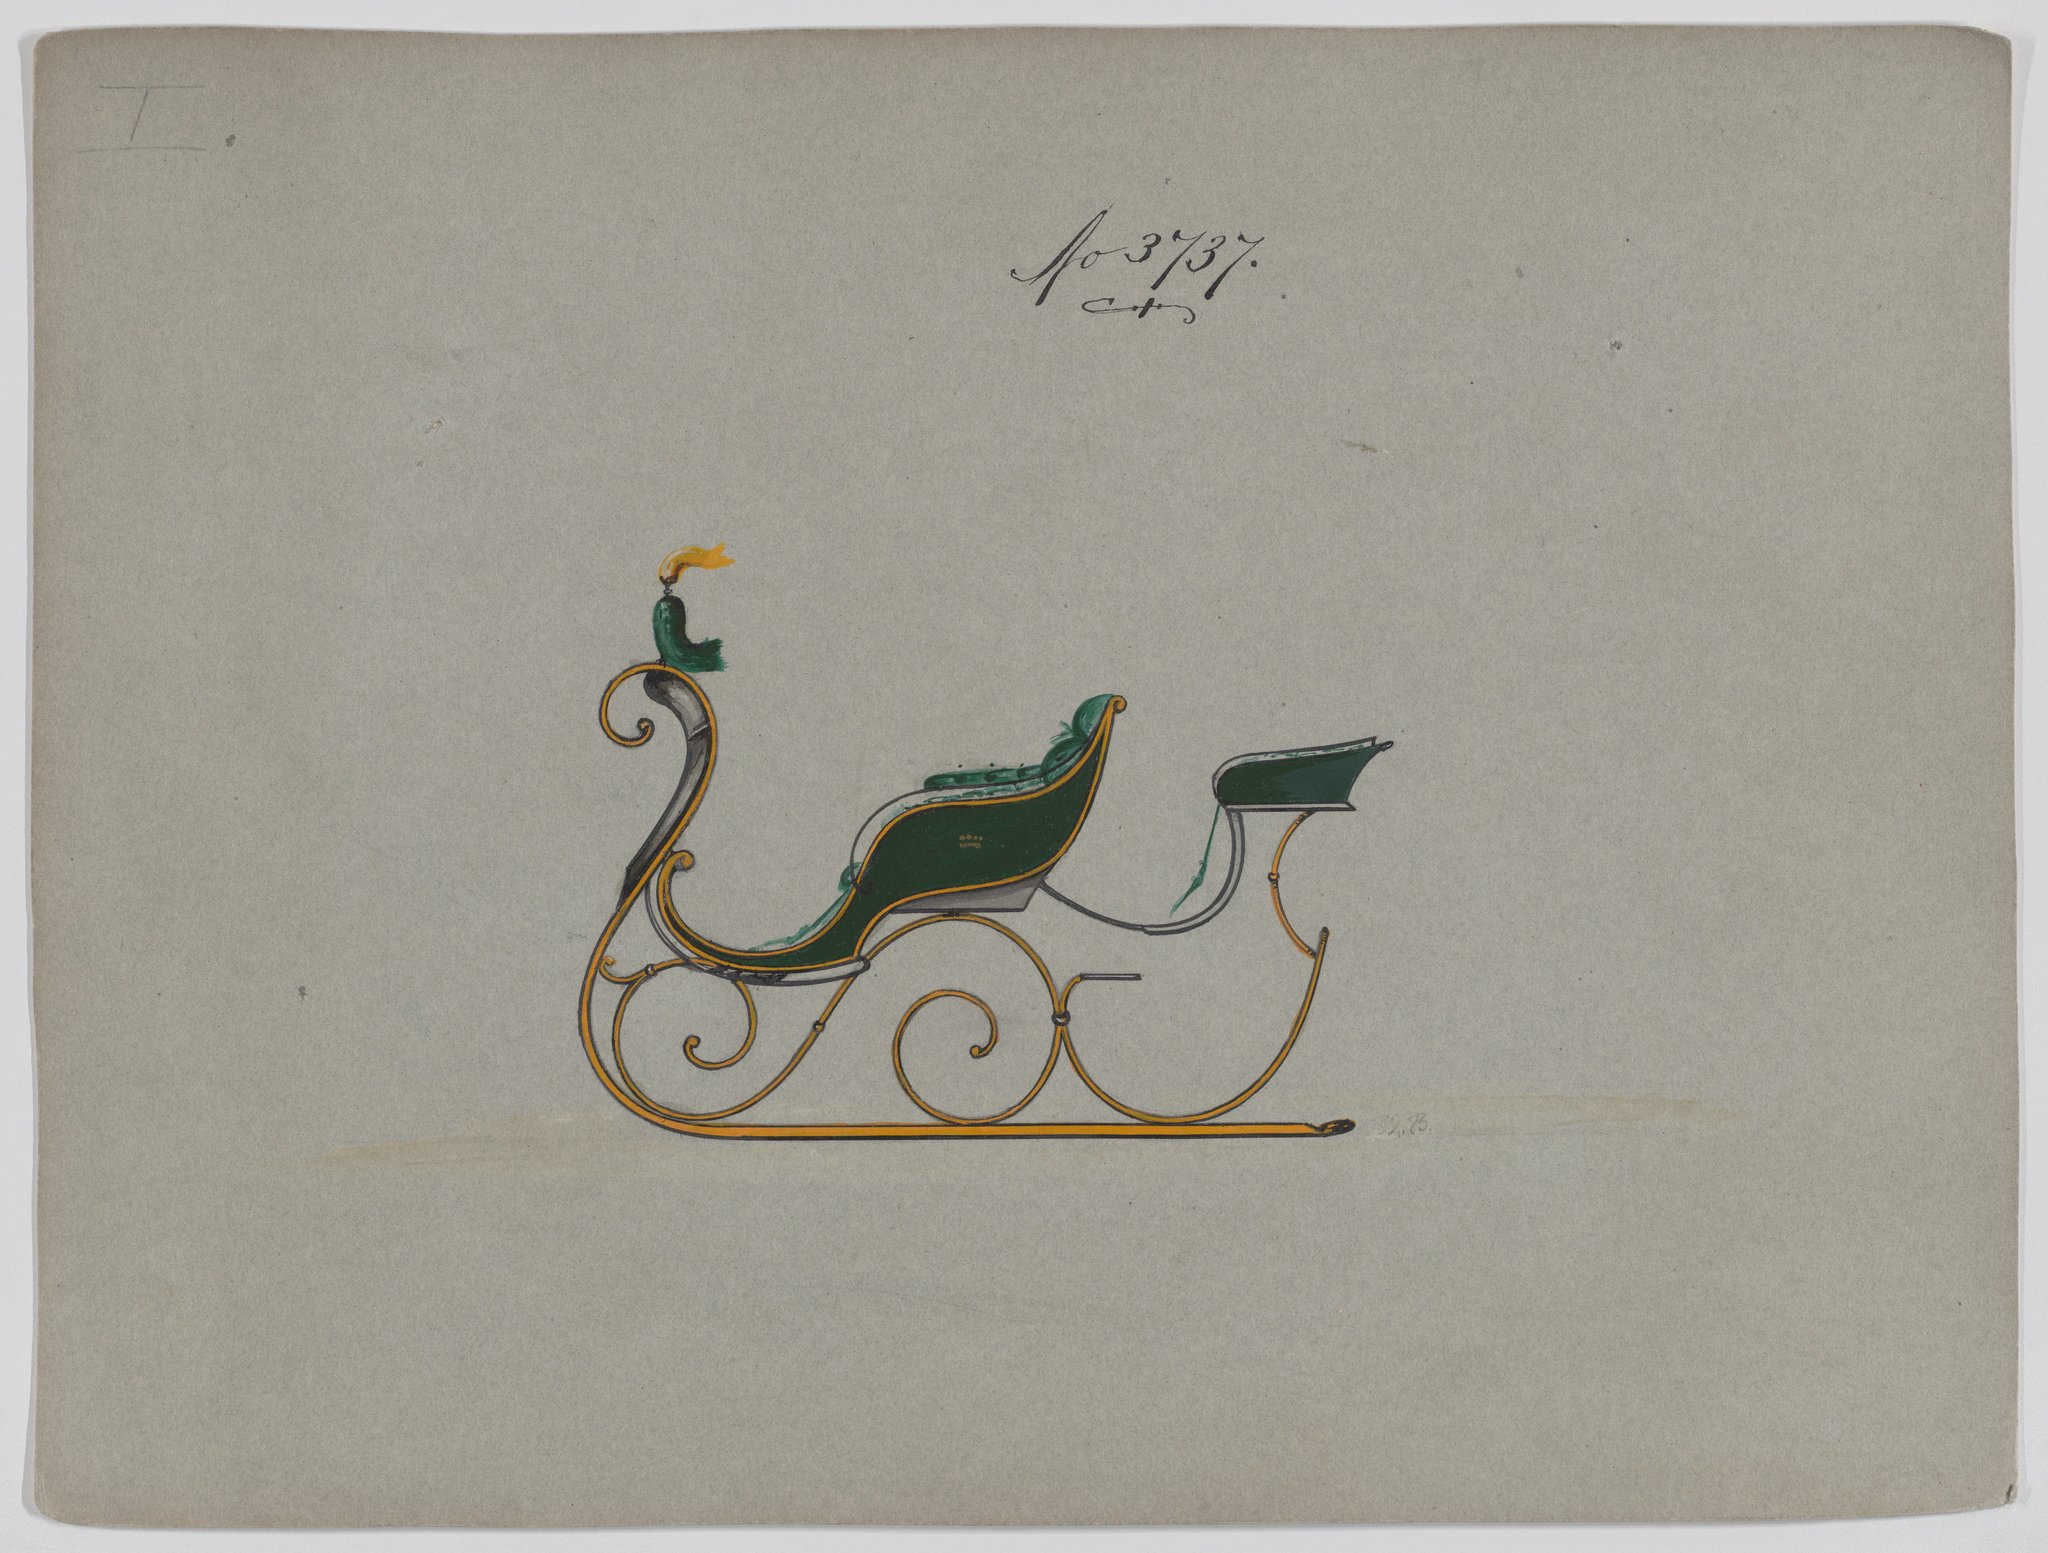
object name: drawing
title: Sleigh with Rumble Seat # 3737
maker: brewster & co.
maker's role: manufacturer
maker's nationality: american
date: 1882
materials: gouache, gum arabic, ink, watercolor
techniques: pen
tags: sleighs